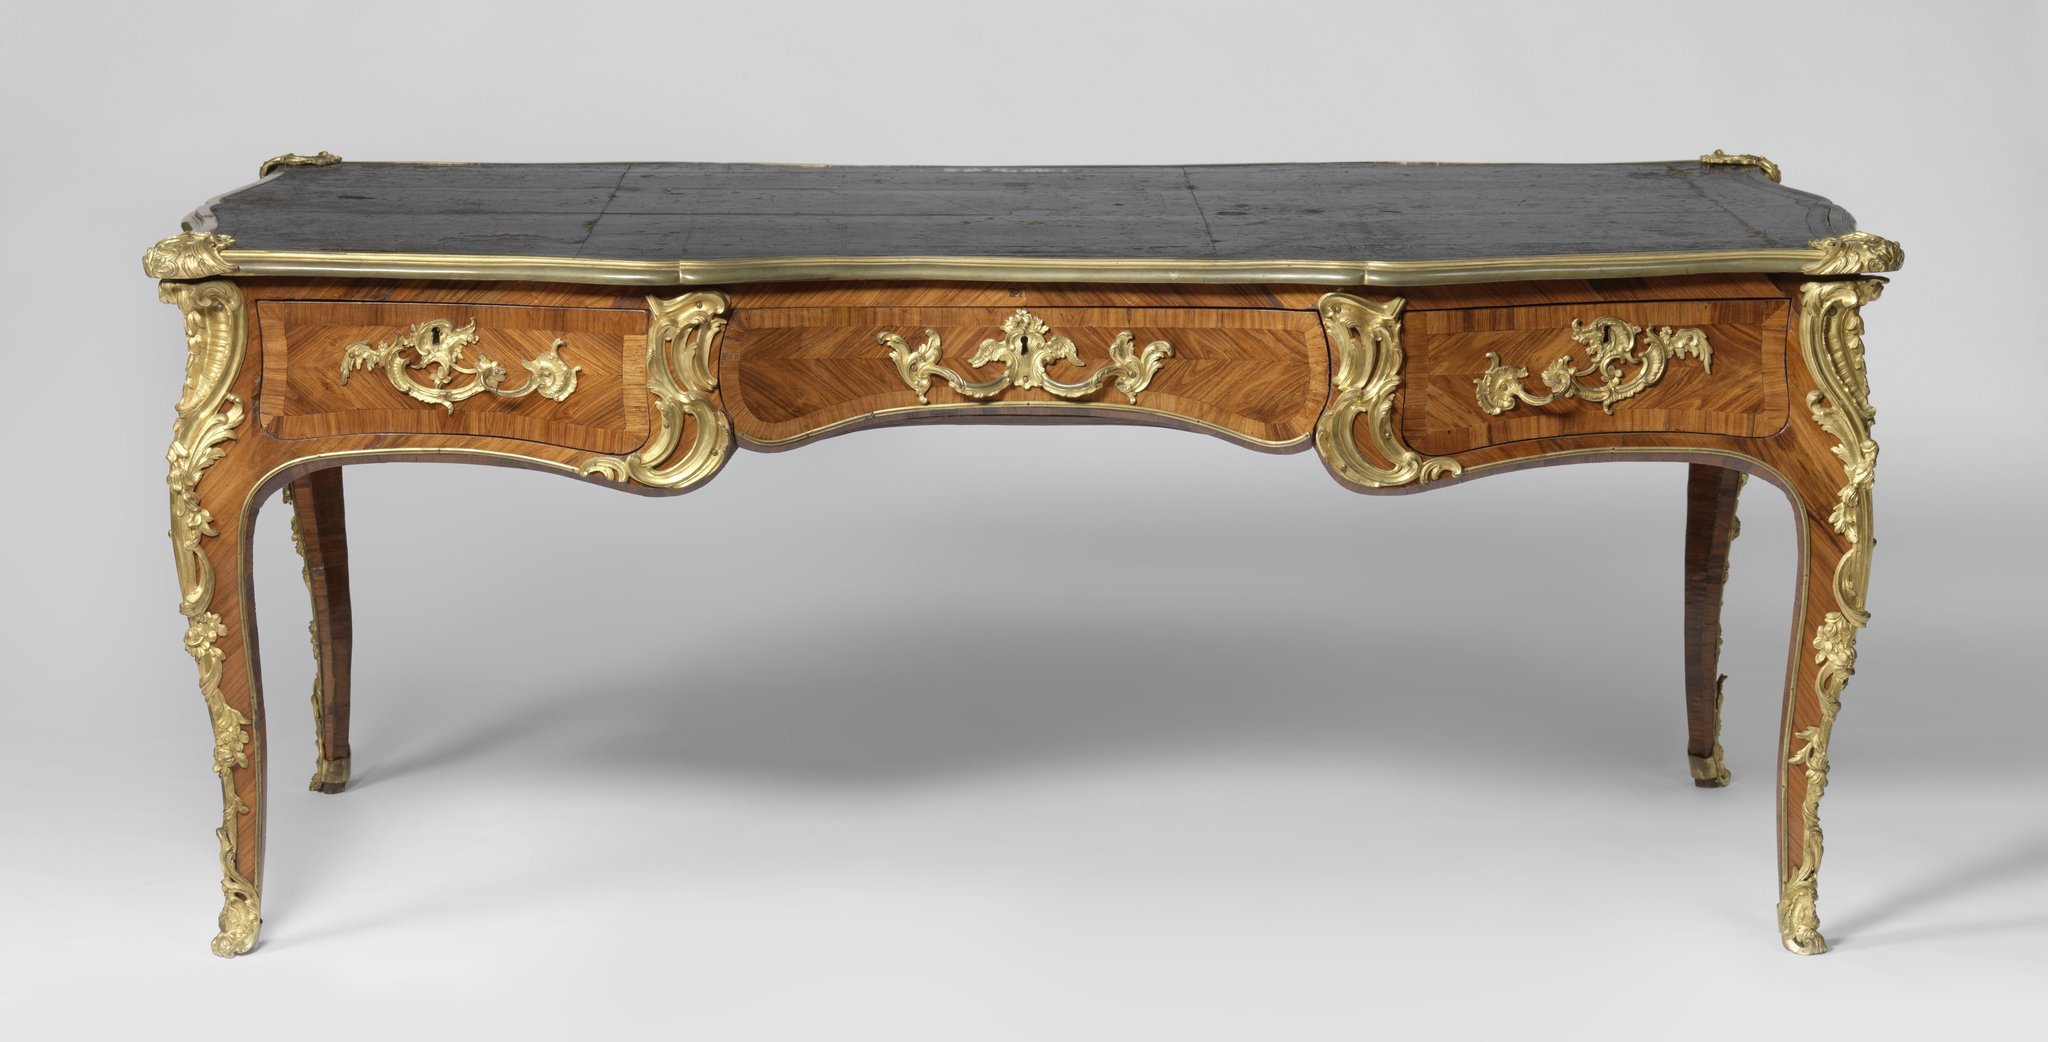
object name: table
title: Writing table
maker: jacques dubois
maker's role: furniture worker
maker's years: -1773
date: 1745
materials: bronze, wood, leather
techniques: gilding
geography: paris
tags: rocaille ornament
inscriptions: stamp: ‘GENIE’, inscription: ‘Reggenerirt durch Georg Noll Tischlergesell aus Laumersheim in Mainz’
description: A table of this format –with a single row of drawers and a leather writing surface –was the preferred writing desk for a gentleman in 18th-century Paris. Its curving form and fanciful mounts are typical of the Rococo style.